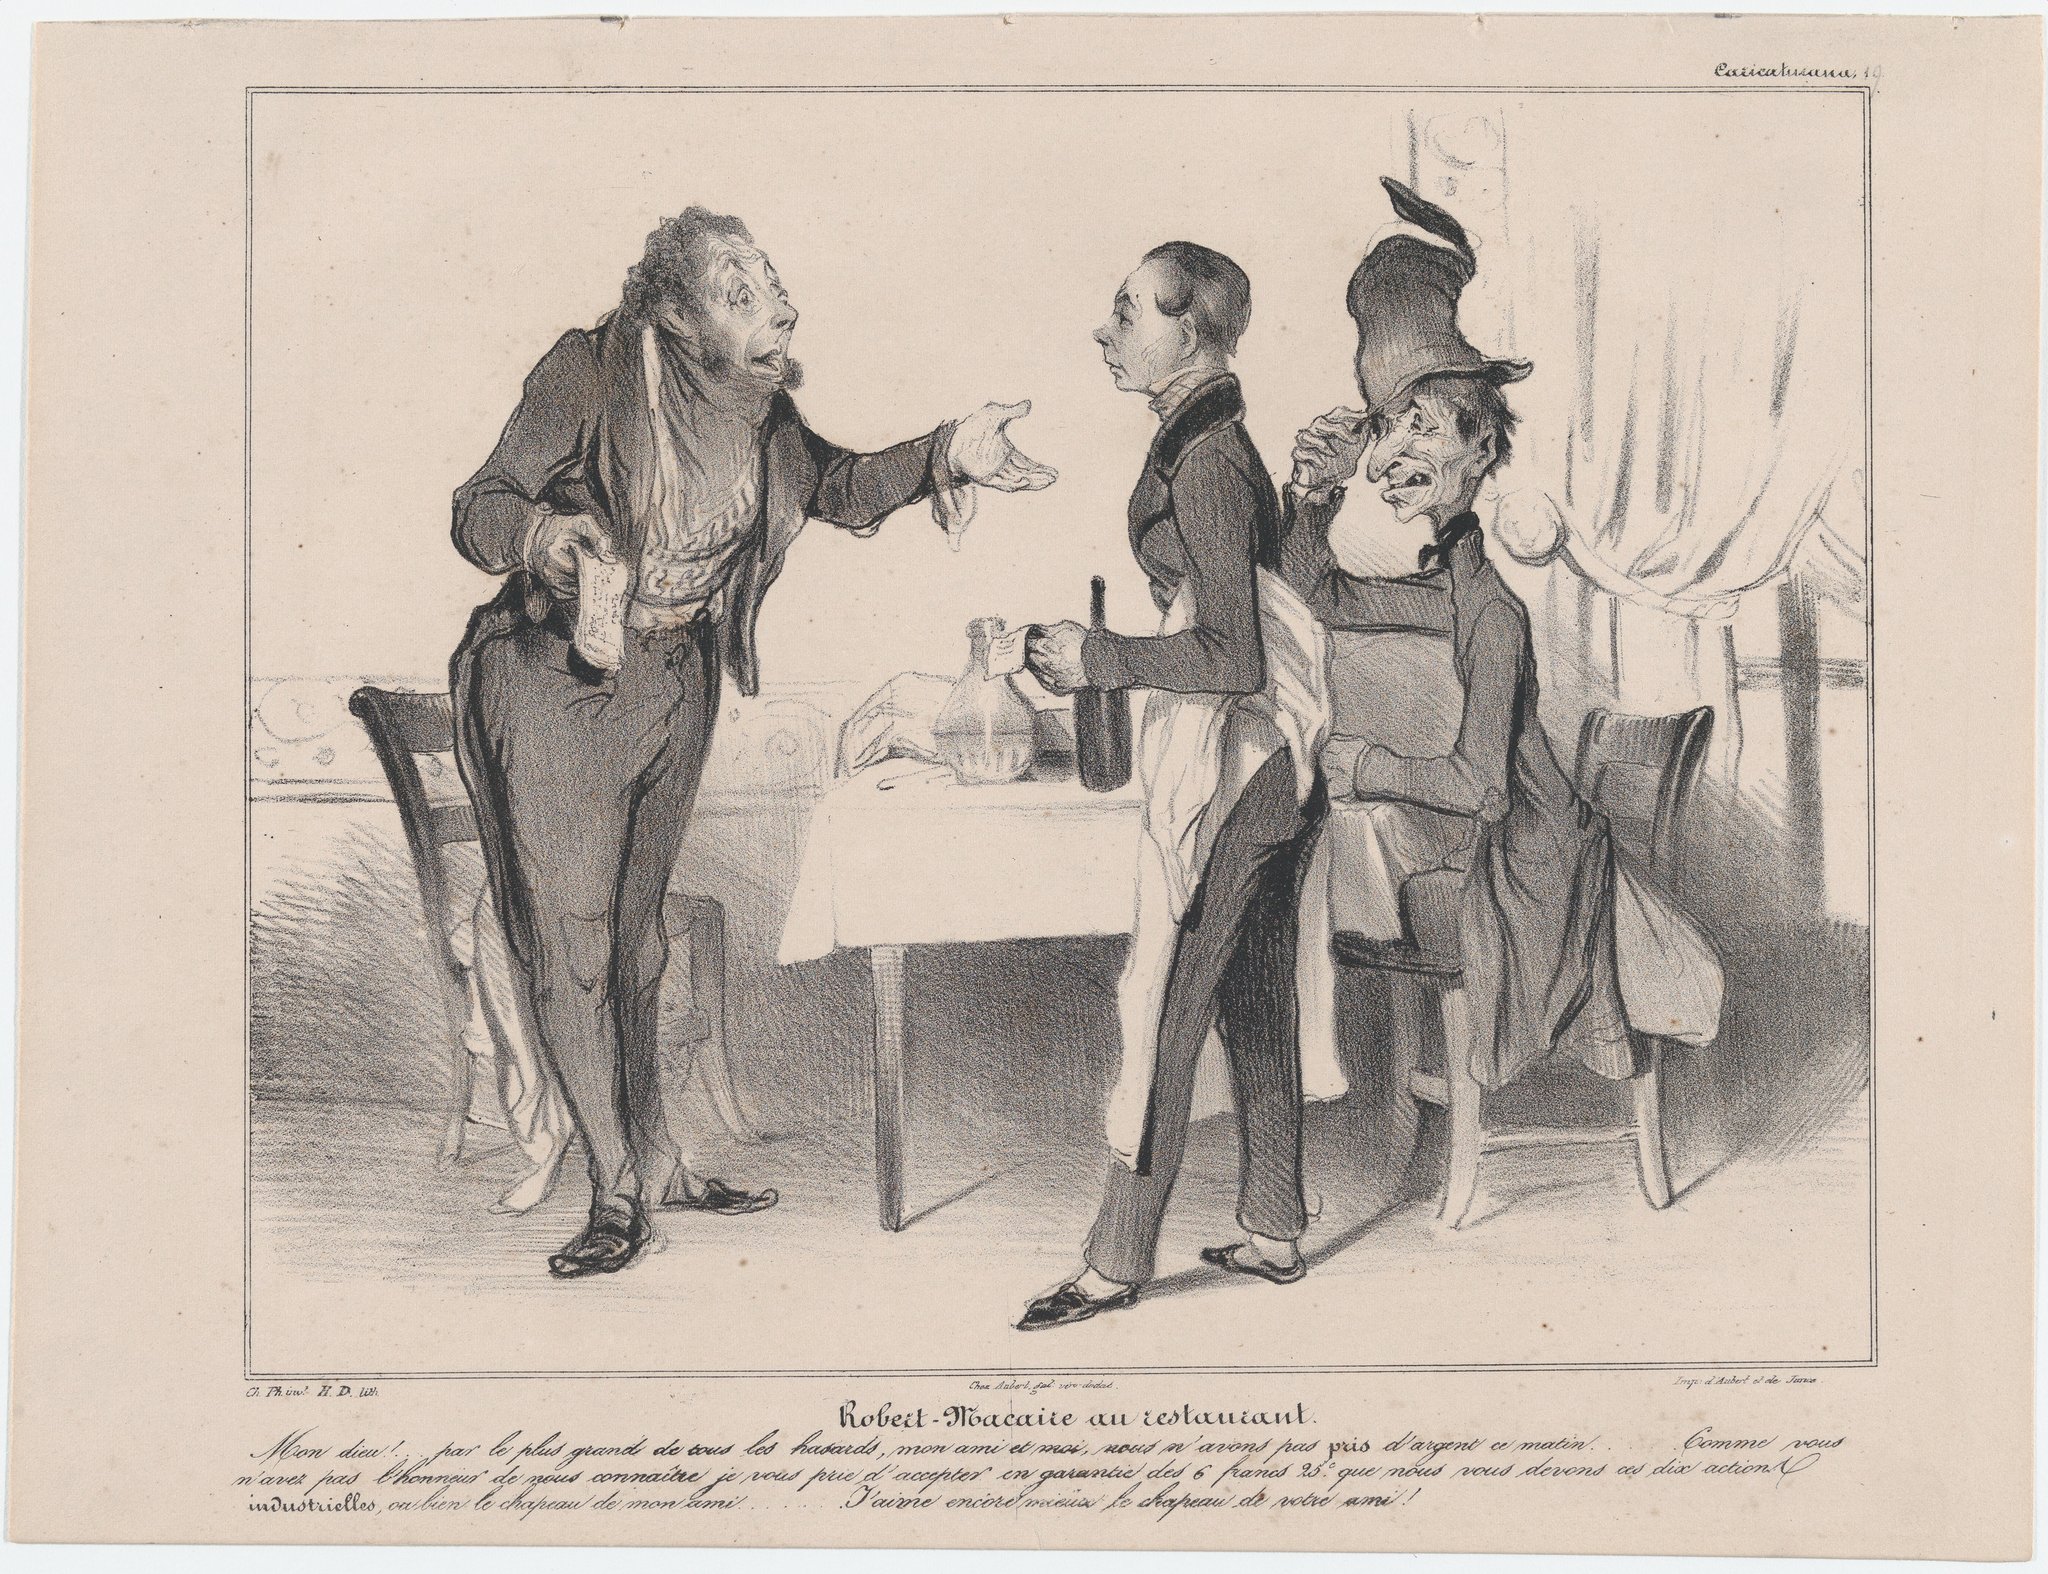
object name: print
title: Plate 19: Robert Macaire at the restaurant, from 'Caricaturana,' published in Les Robert Macaires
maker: honoré daumier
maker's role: artist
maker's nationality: french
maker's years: 1808-1879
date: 1838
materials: paper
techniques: lithograph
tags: satire,restaurants,men